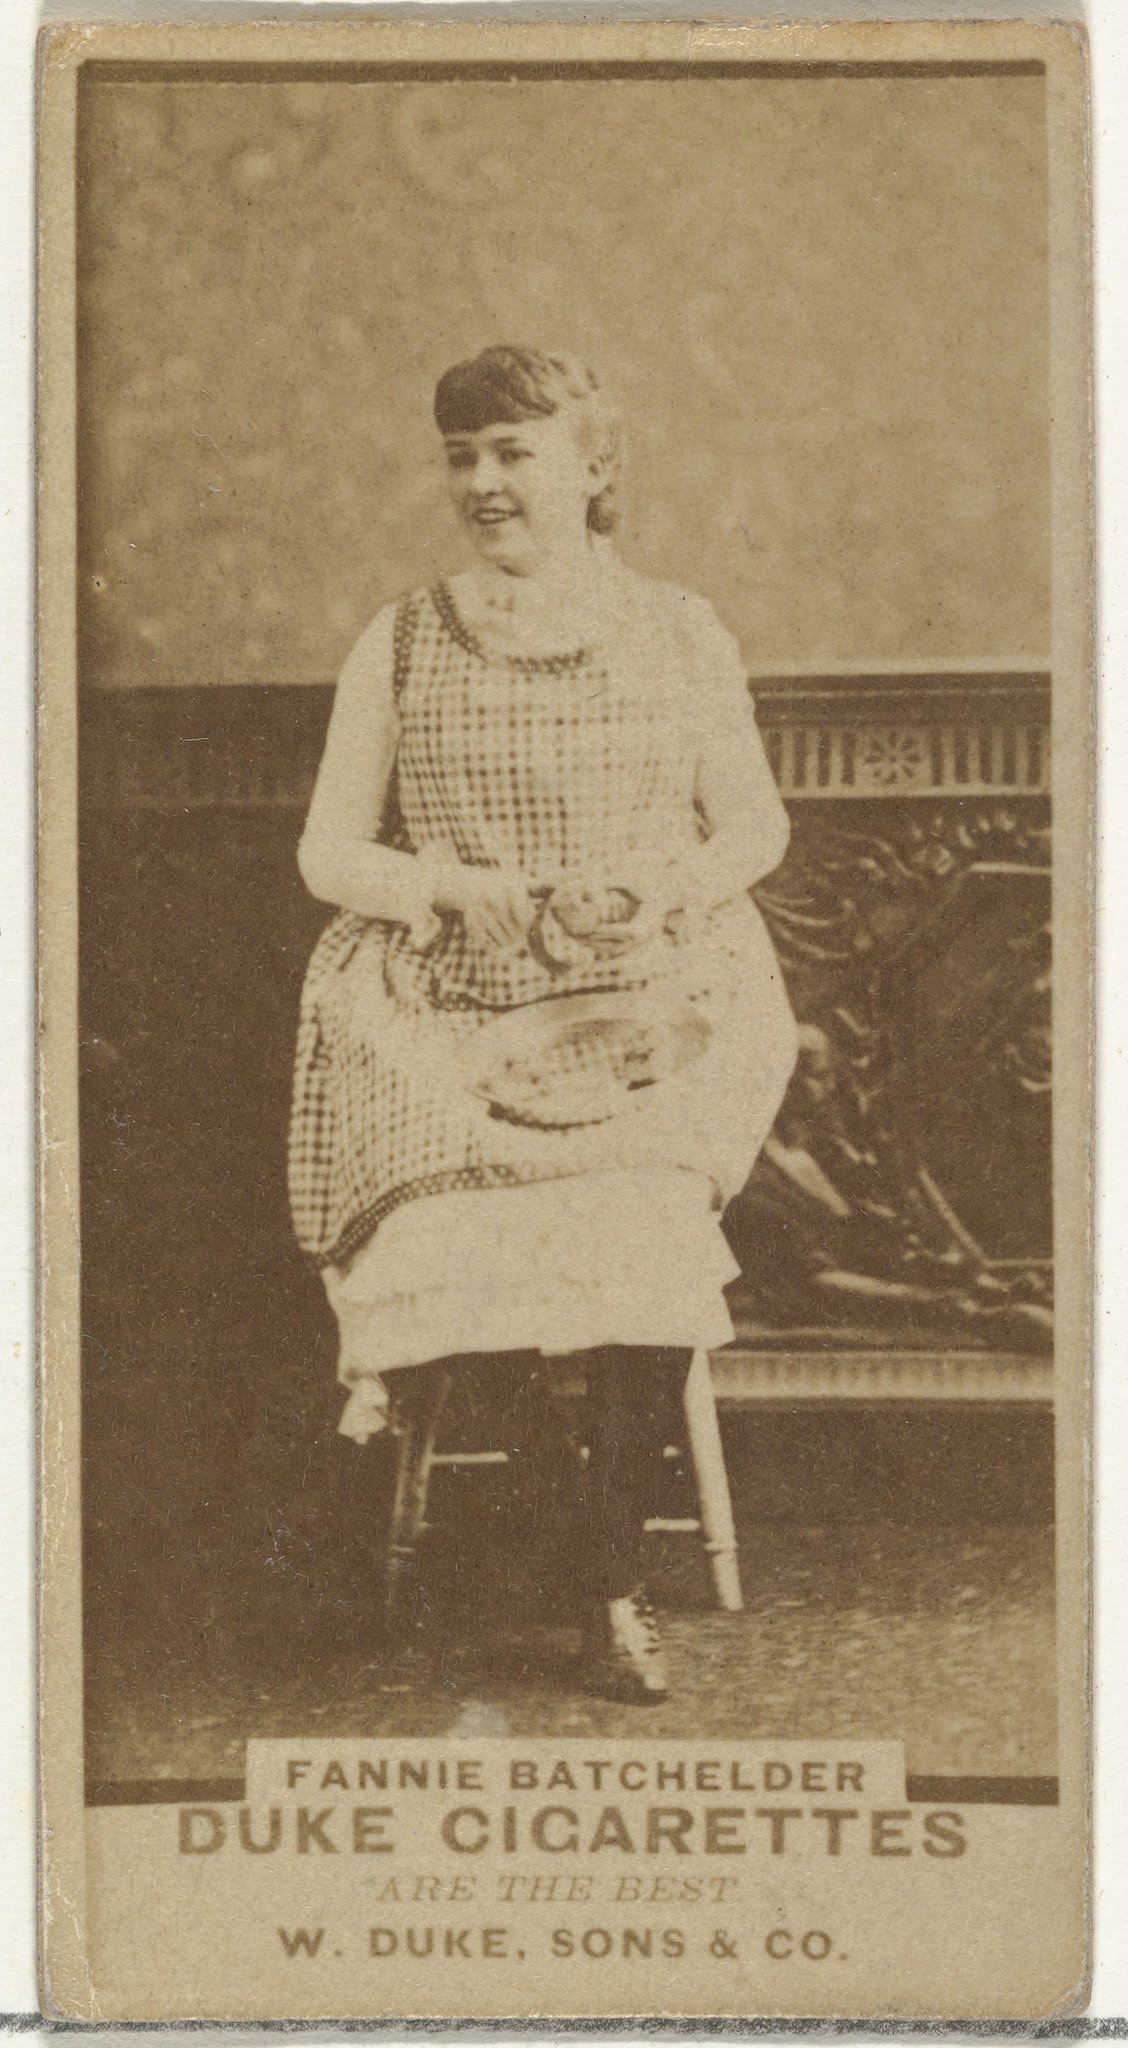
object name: photograph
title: Fannie Batchelder, from the Actors and Actresses series (N145-7) issued by Duke Sons & Co. to promote Duke Cigarettes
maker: w. duke, sons & co.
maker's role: publisher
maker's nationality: american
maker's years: 1870-1920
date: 1880-1889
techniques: albumen silver print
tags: portraits,women,actresses